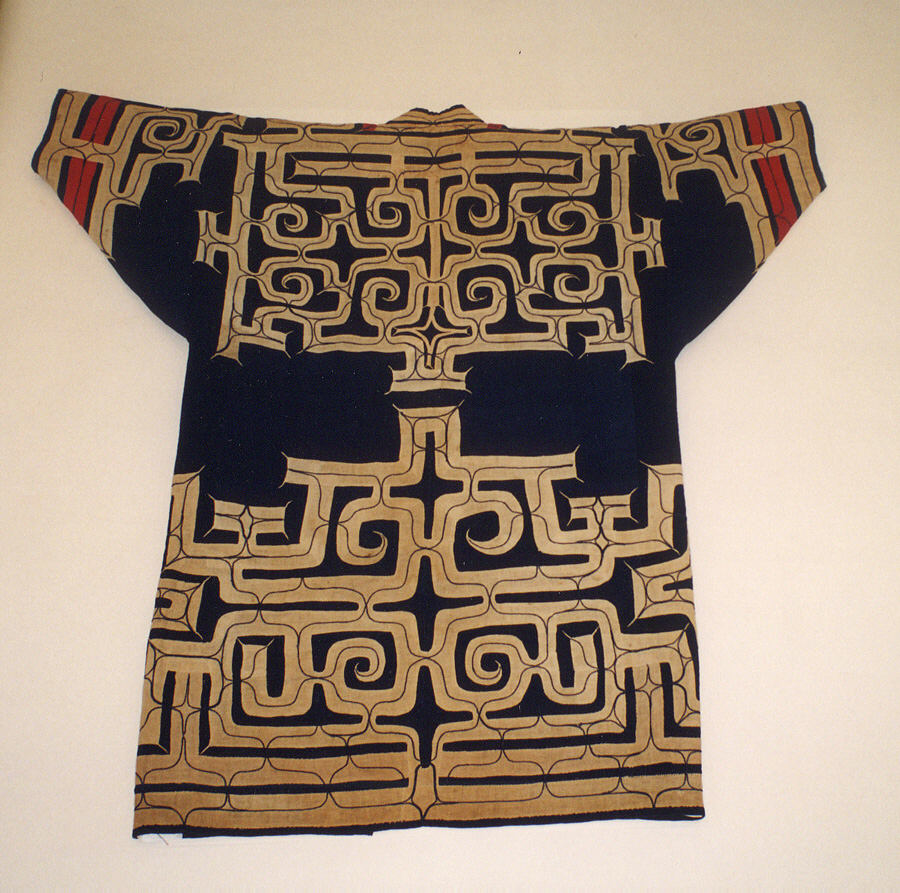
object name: robe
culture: japanese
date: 1801-1900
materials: cotton